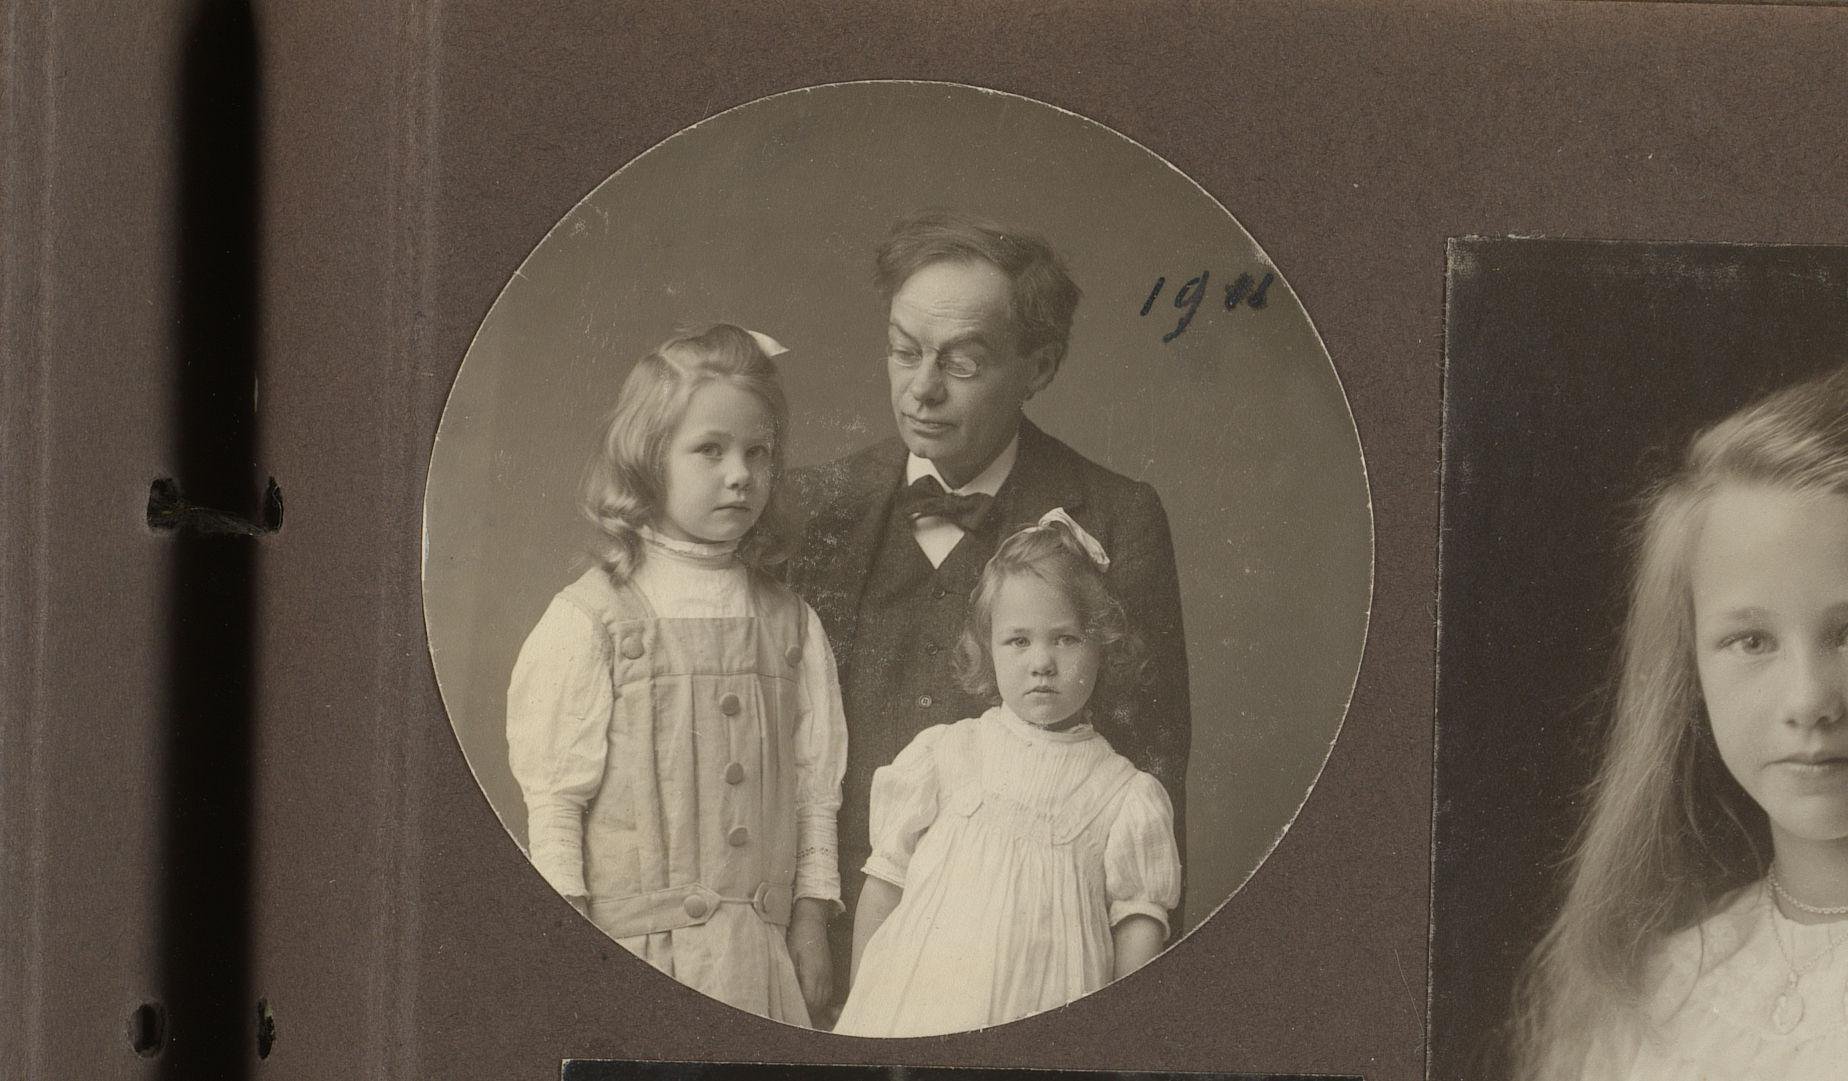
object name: photograph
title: Portret van Alphons Diepenbrock met zijn dochters Joanna en Thea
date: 1911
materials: paper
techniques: cutting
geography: netherlands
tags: alphons diepenbrock, father with daughter(s) (father-love), historical persons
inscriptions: date: ‘1911’